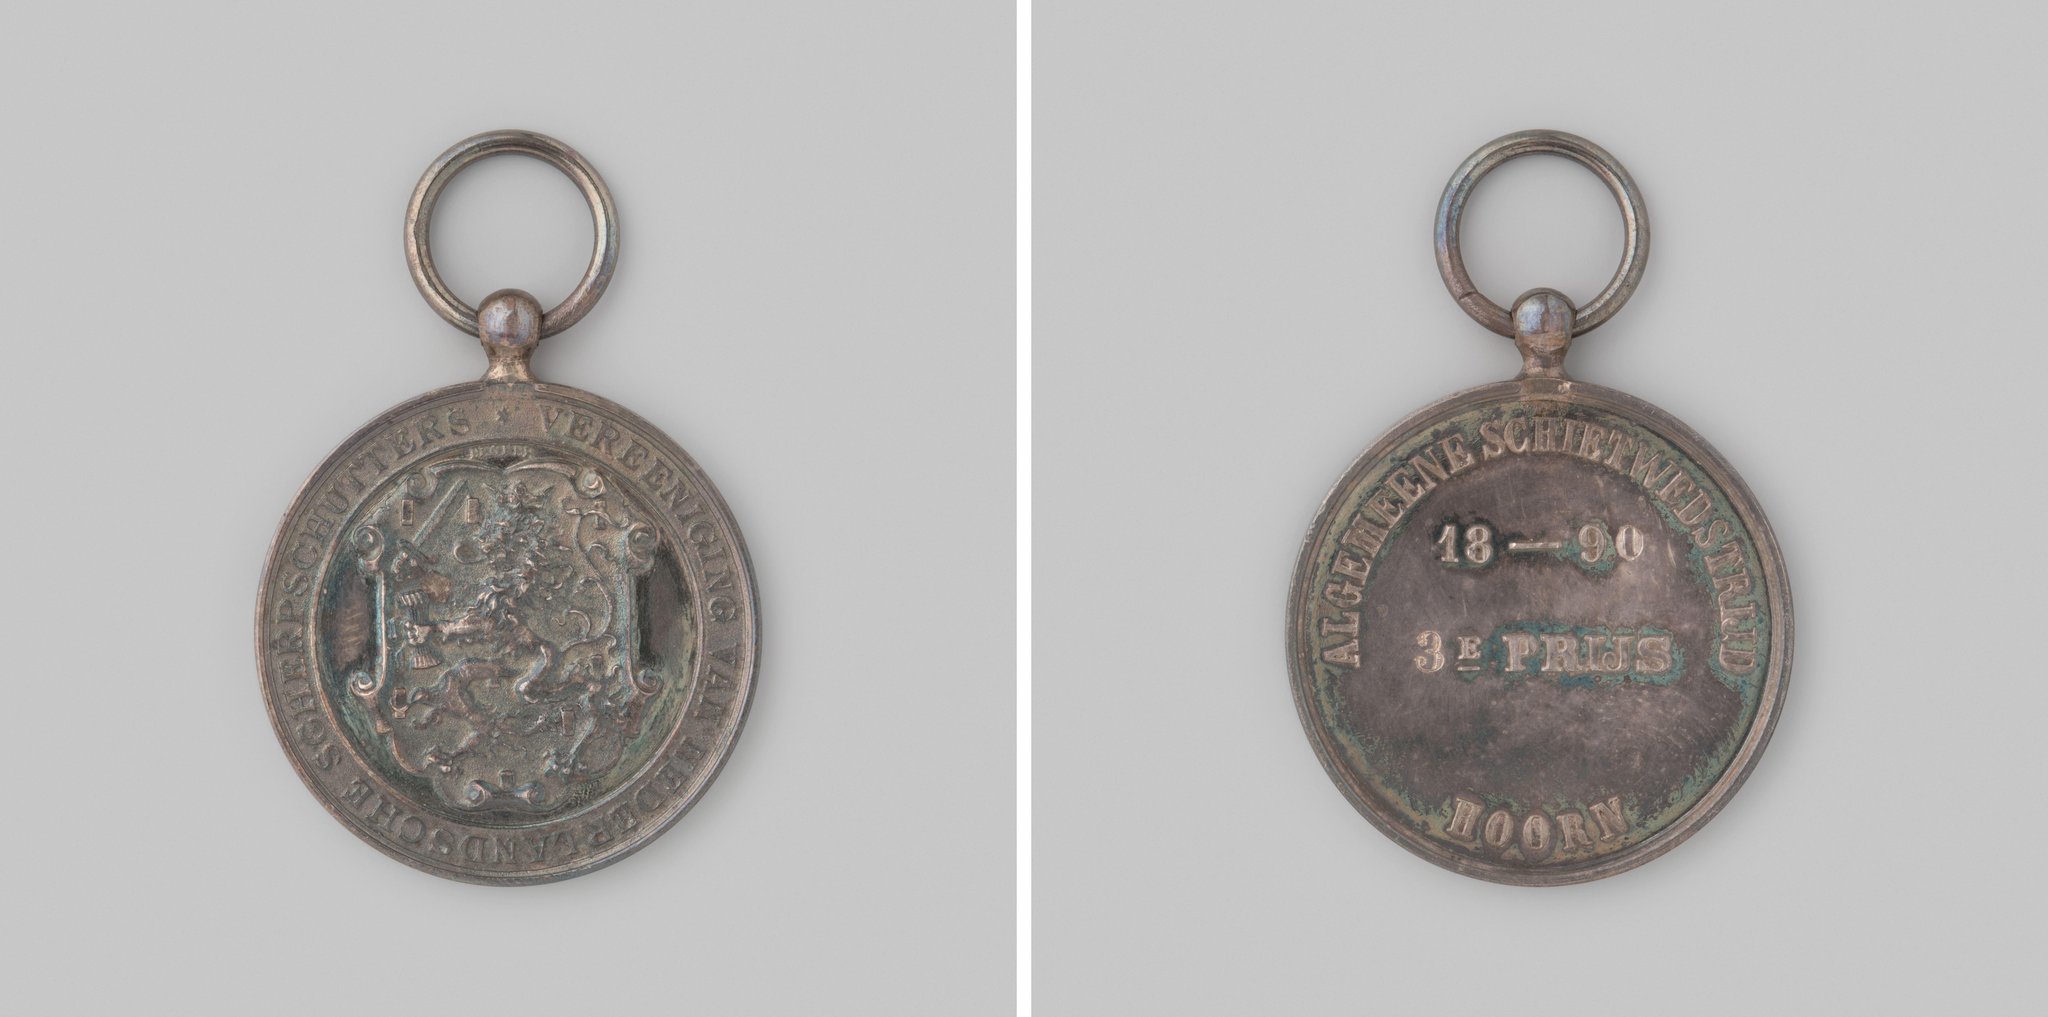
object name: draagpenning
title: Prijspennning van de Vereeniging van Nederlandsche Scherpschutters, salvovuur, derde prijs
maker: Anonymous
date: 1890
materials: silver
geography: hoorn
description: Verguld zilveren penning met oog en ring van de Vereeniging van Nederlandsche Scherpschutters, behaald door de detachementen van het 1e en 2e bataljon regiment Schutterij te Amsterdam, 1890. Schietwedstrijd op 25 augustus 1890 in Hoorn. Voorzijde: het Nederlandse wapen in renaissancestijl. Omschrift: VEREENIGING VAN NEDERLANDSCHE SCHERPSCHUTTERS. Keerzijde: ALGEMENE SCHIETWEDSTRIJD HOORN. In het veld gegraveerd: 18-90 / 3e PRIJS.